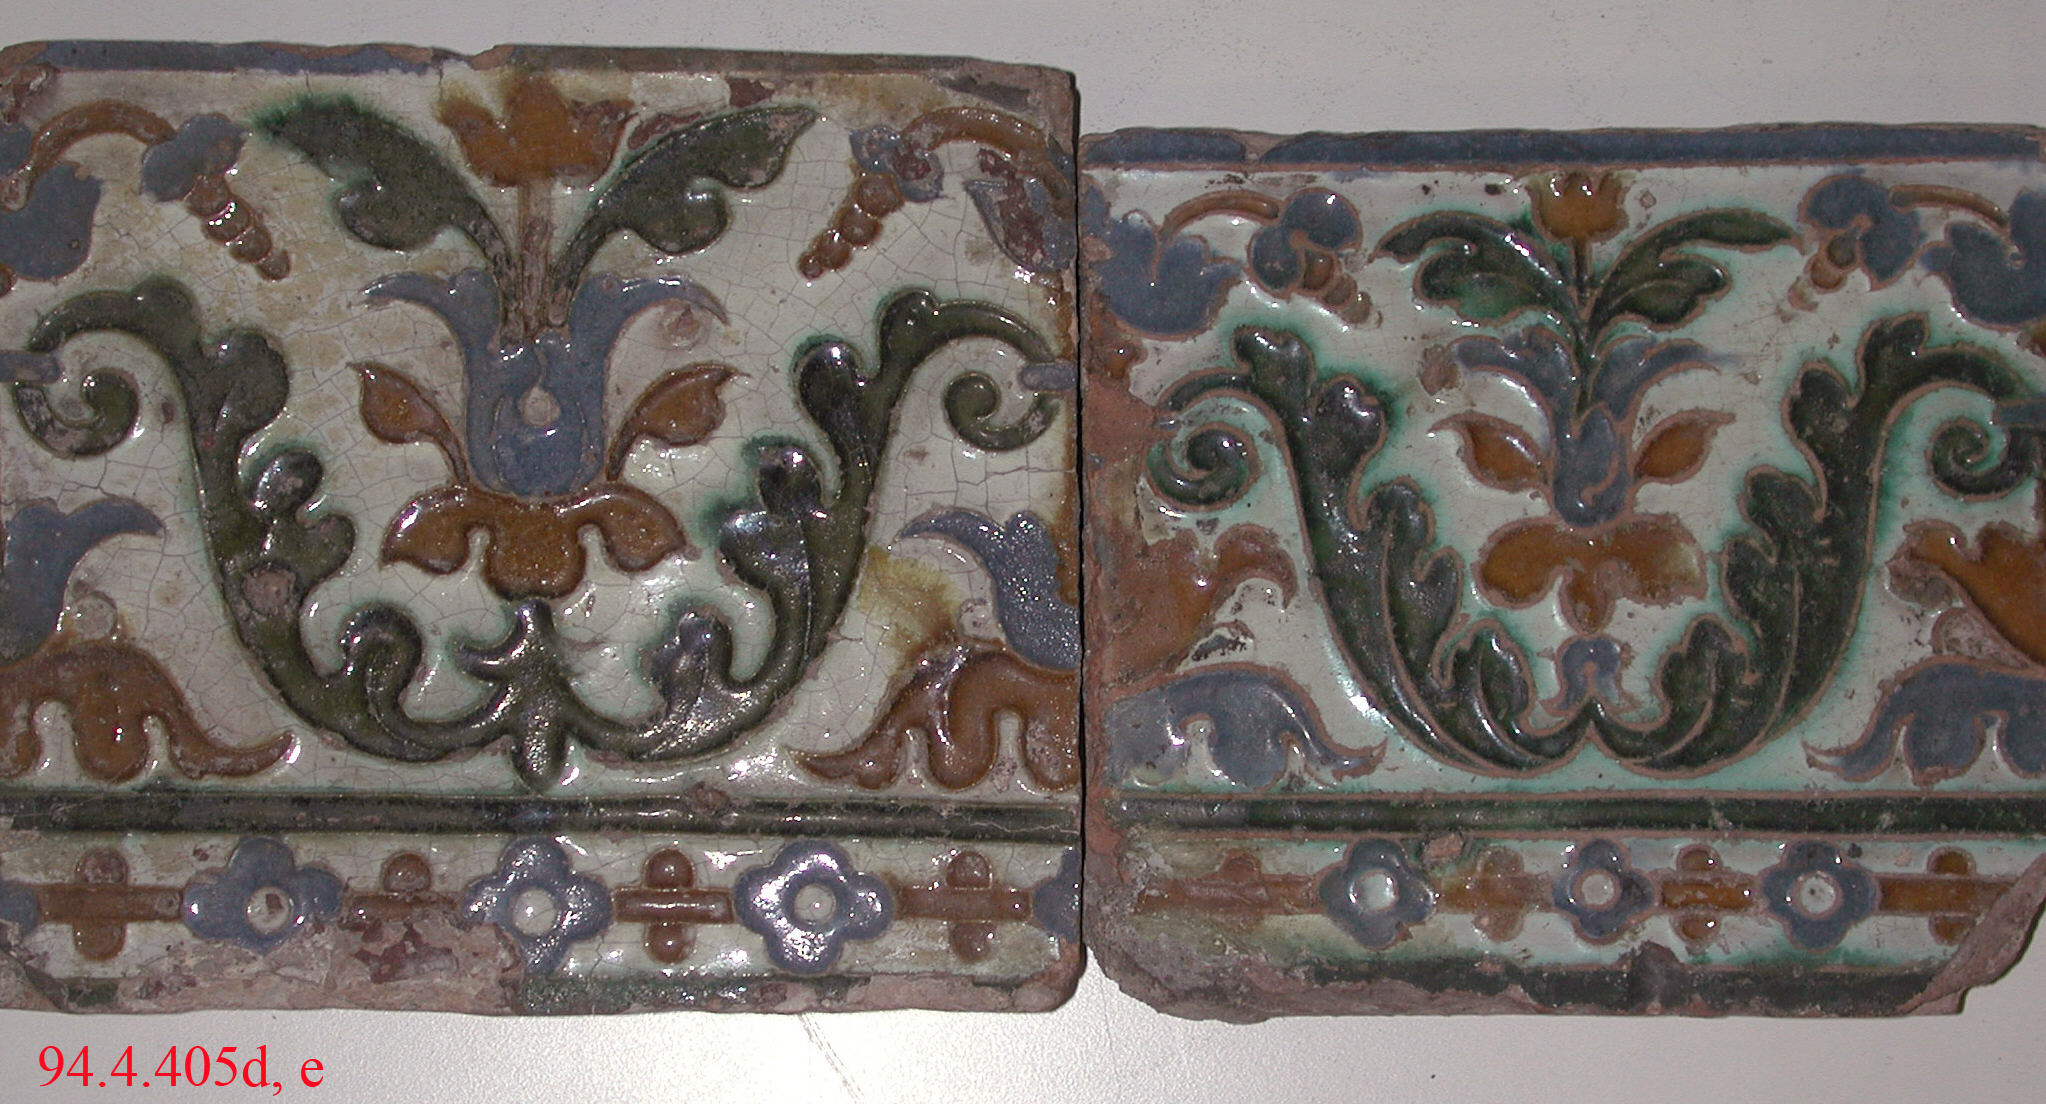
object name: wall tile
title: Wall tiles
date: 1501-1600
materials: earthenware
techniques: glazing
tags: flowers